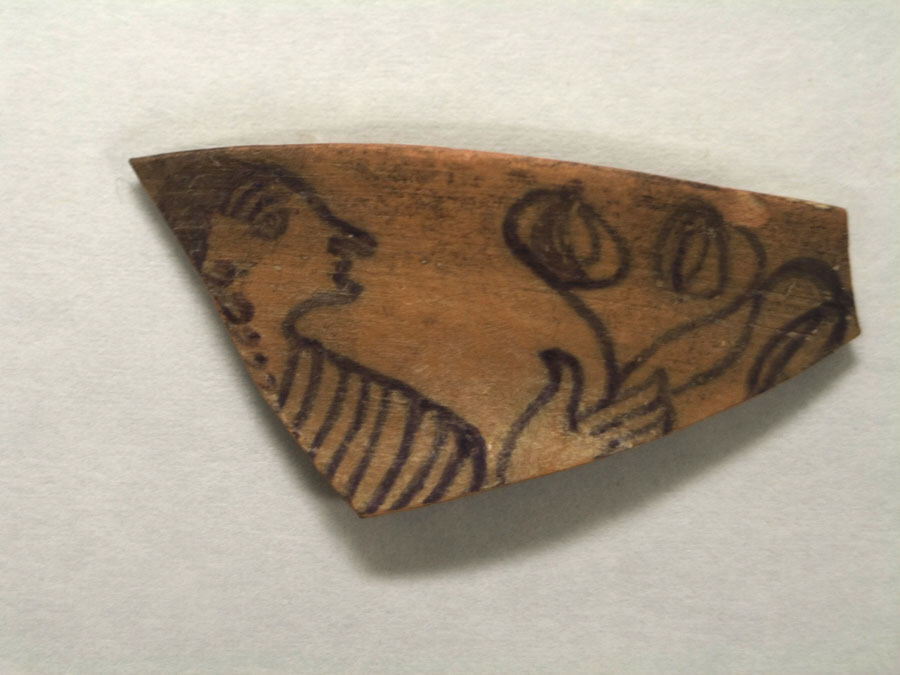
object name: shard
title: Shard: Offerer with Flower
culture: pakistani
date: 301-500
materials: terracotta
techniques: painting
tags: human figures,gandhara,flowers